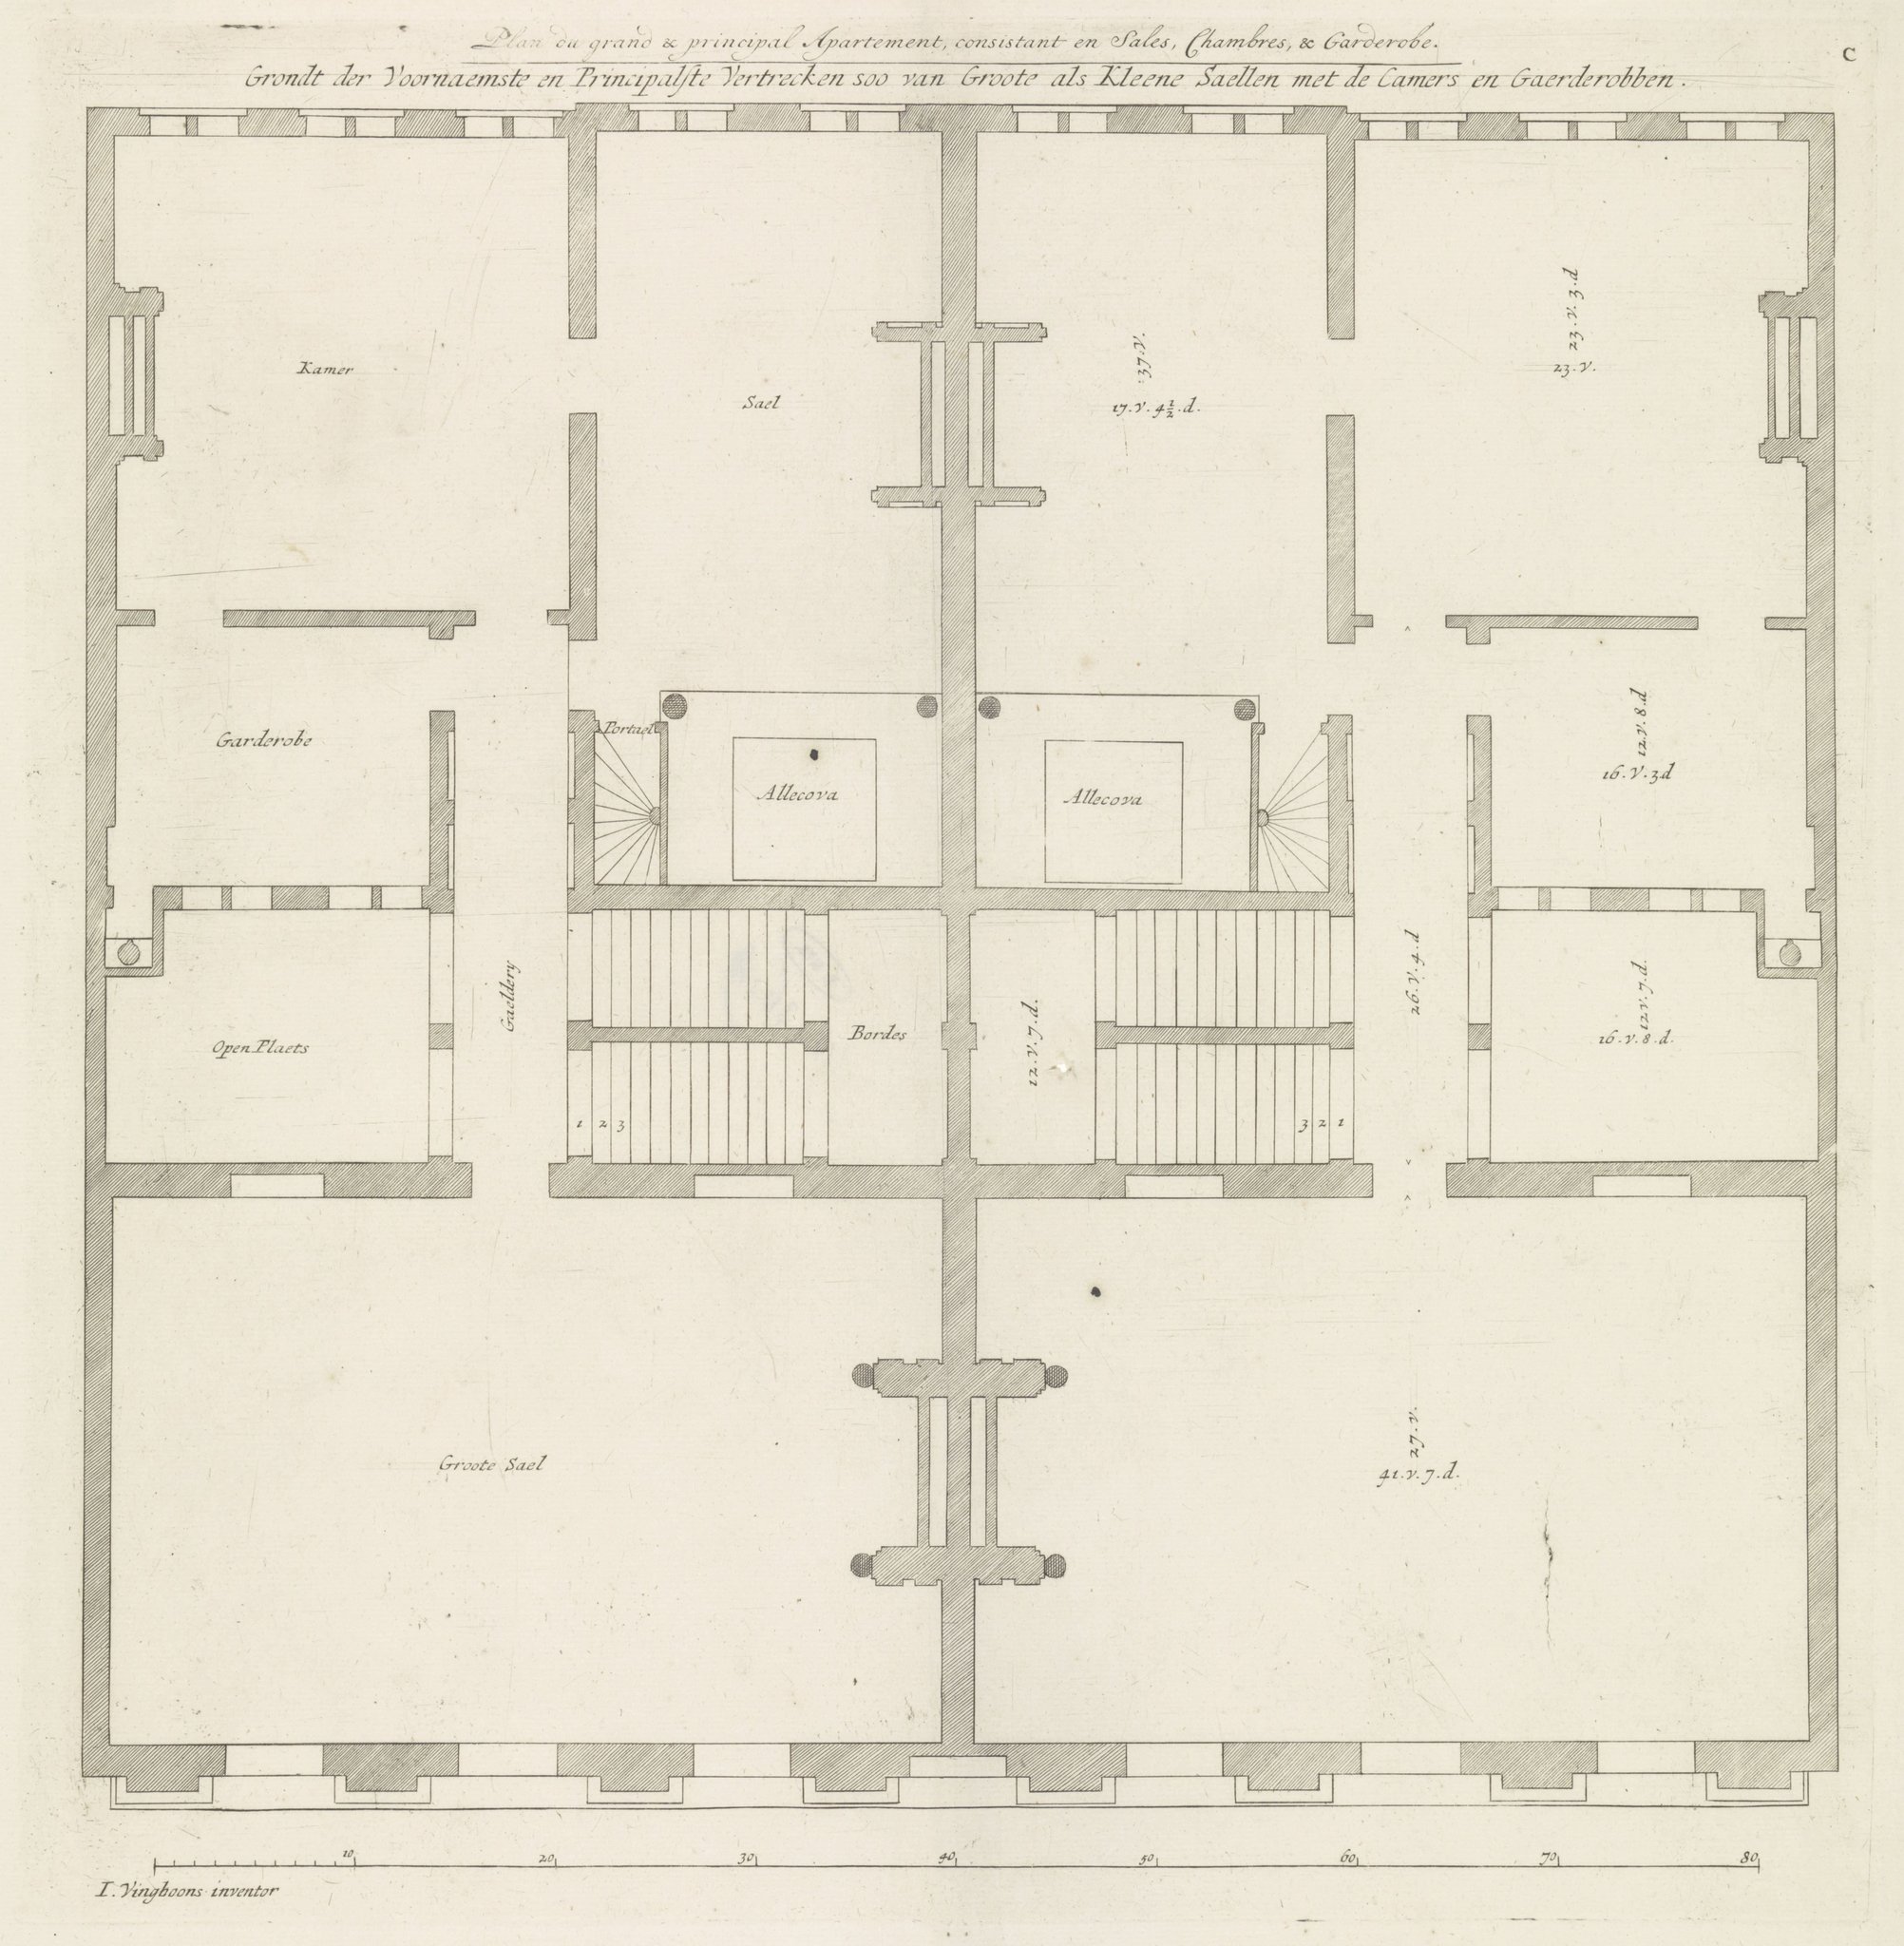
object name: print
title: Plattegrond van de begane grond van het Trippenhuis te Amsterdam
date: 1664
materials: paper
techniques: etching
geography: amsterdam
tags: plan ~ architecture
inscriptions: collector's mark: Lugt 2228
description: Prent gebruikt in: Vingboons, J. Het huys van de heeren Louys en Hendrick Trip. Amsterdam: Justus en Joan Vingboons, verkocht bij Joan Blaeu, 1664.